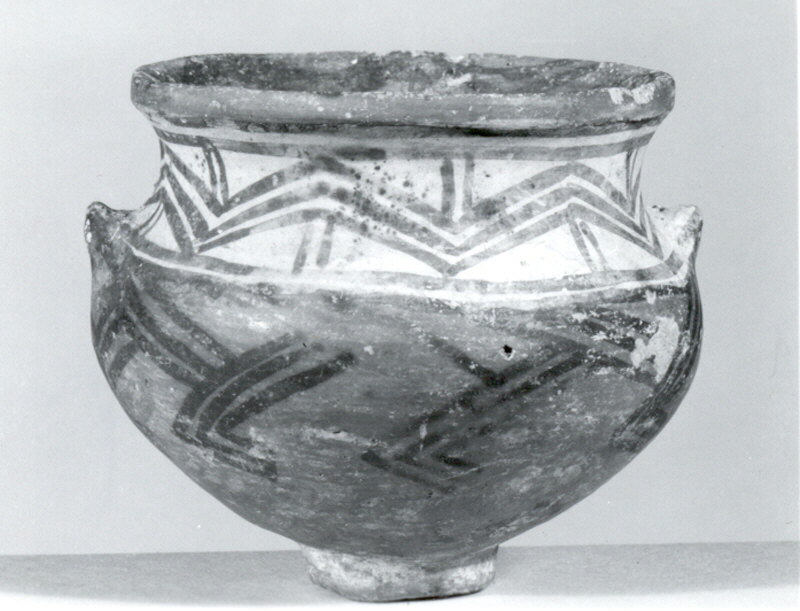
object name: bowl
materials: ceramic, paint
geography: central iran